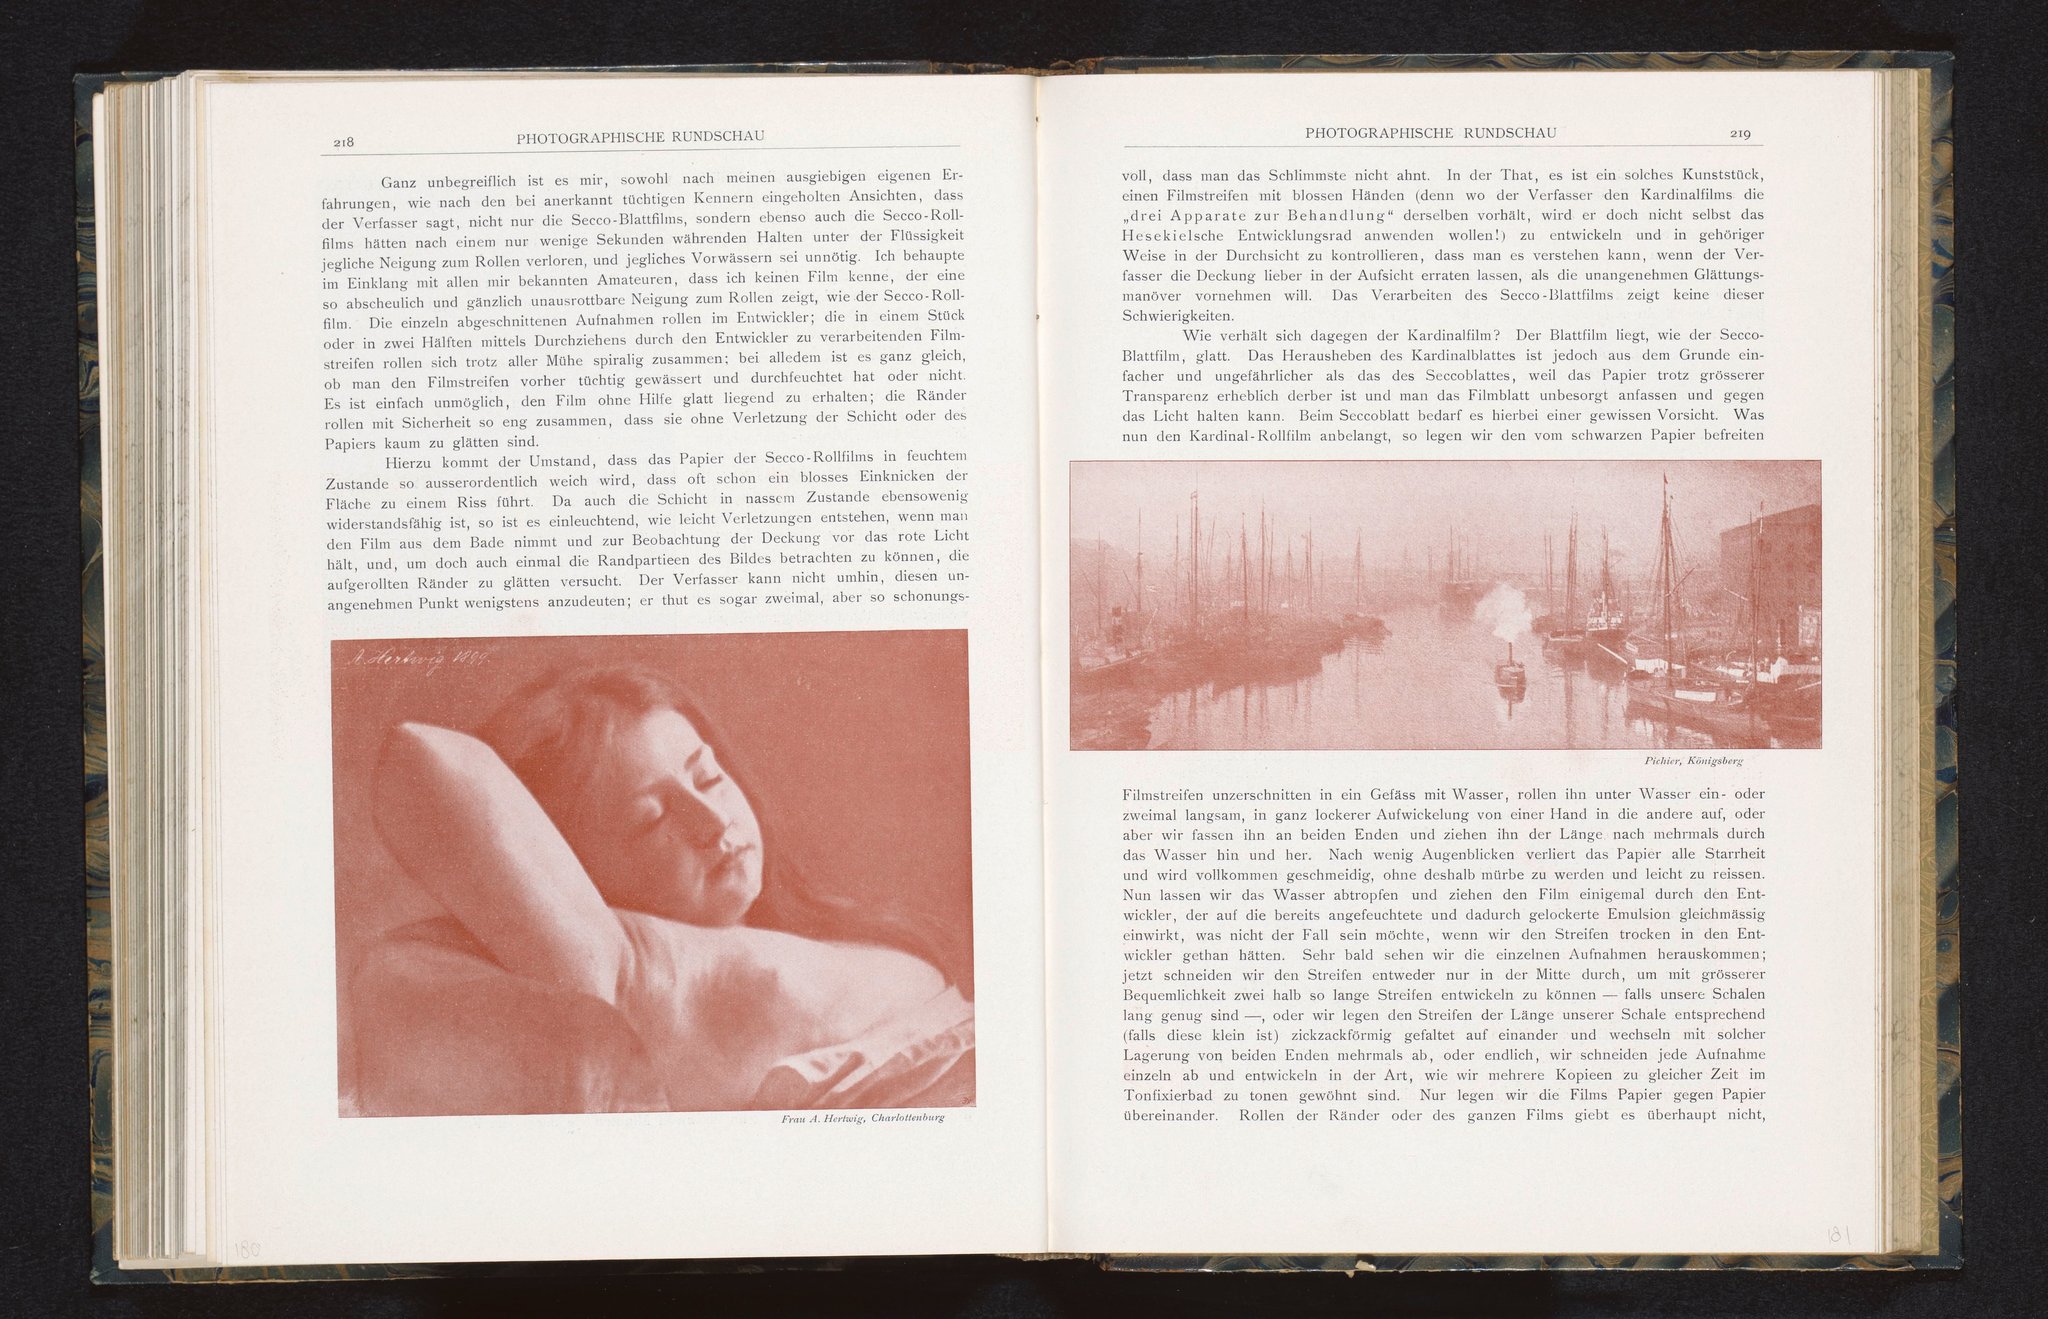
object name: page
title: Portret van een onbekende vrouw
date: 1895-1900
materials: paper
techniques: autotype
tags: adult woman, anonymous historical person portrayed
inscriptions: monogram: ‘BX’